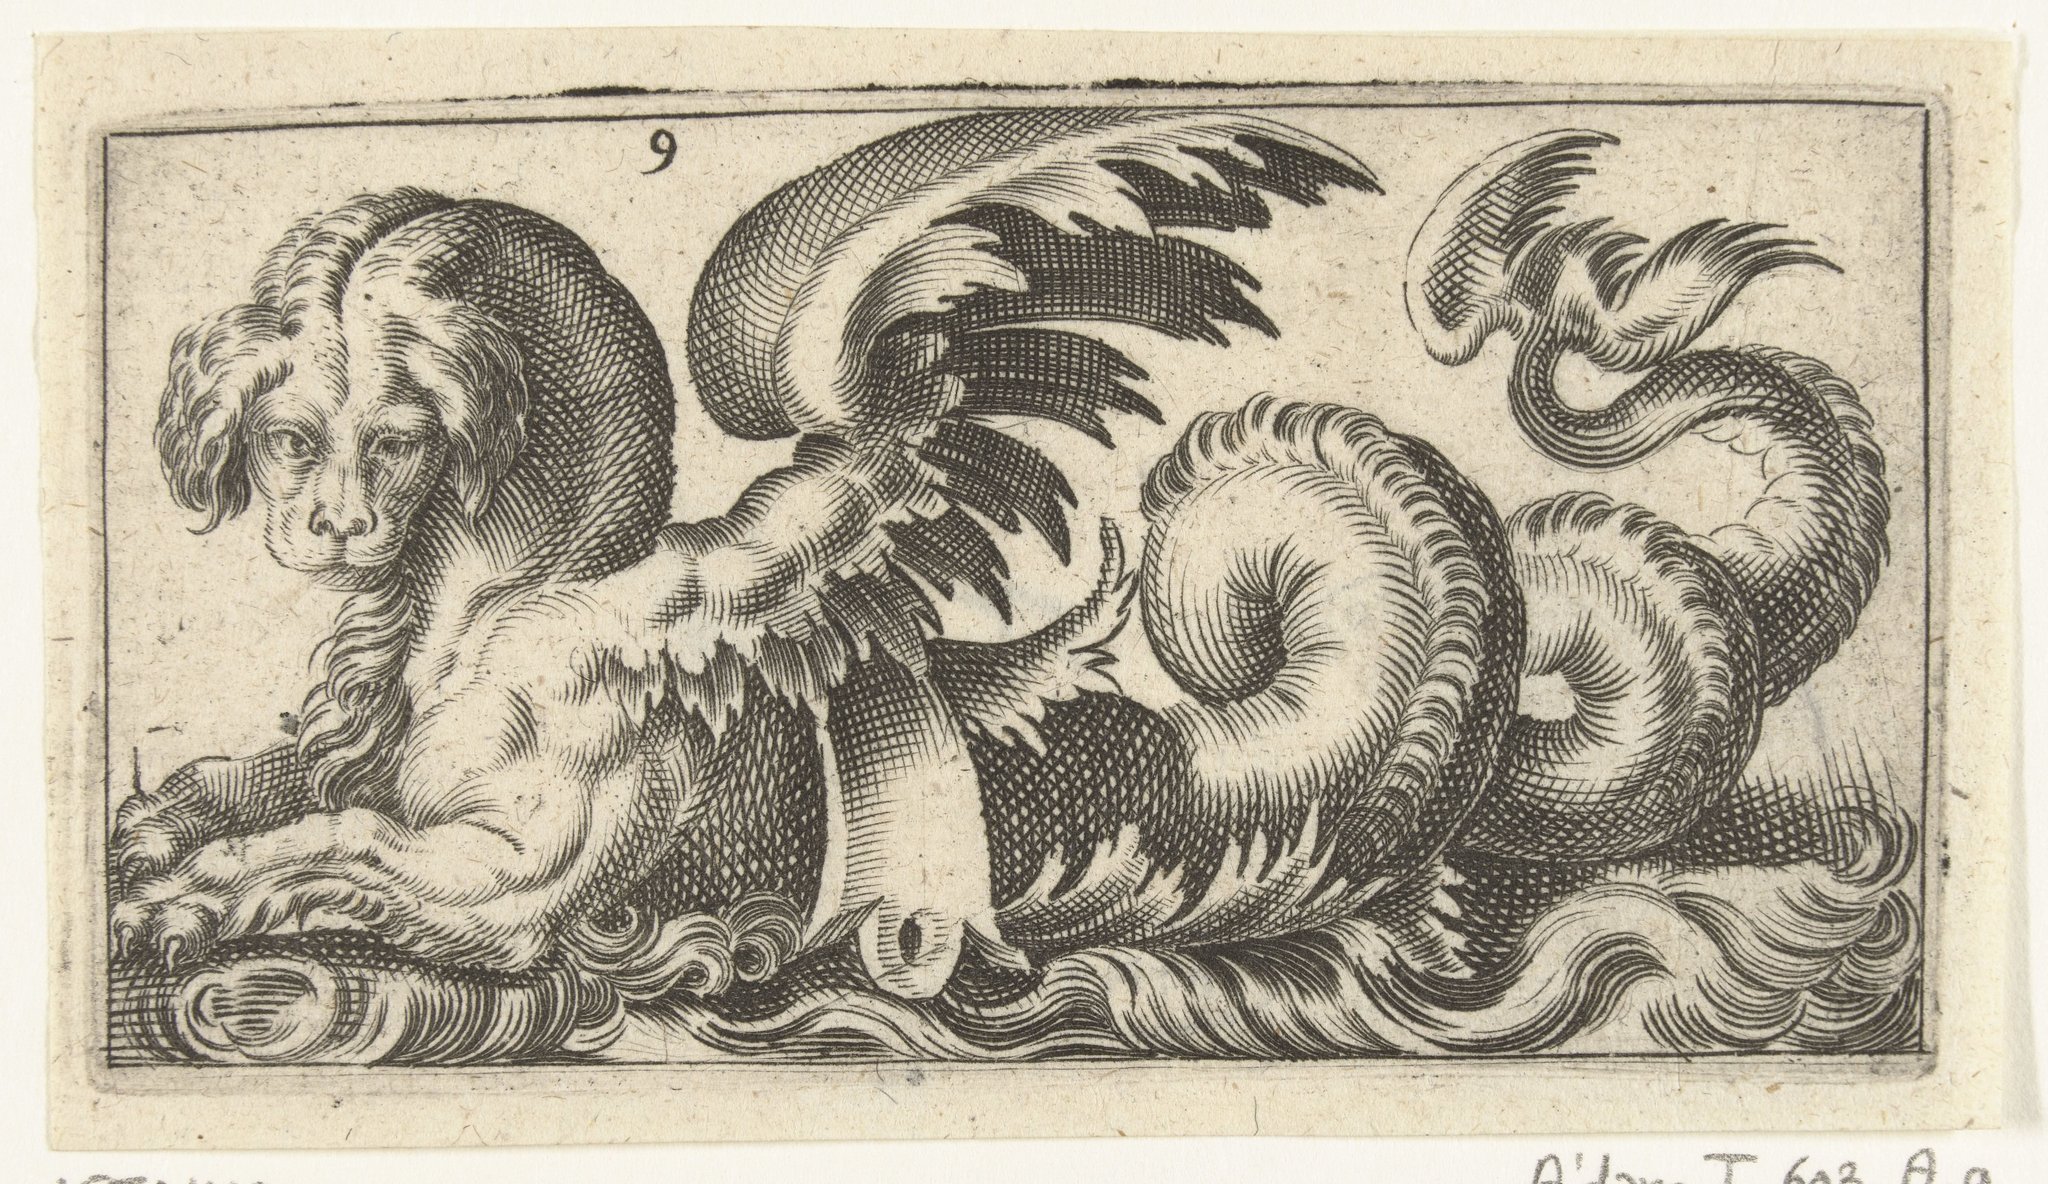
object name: print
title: Gevleugelde zeehond met een soort zadel op zijn rug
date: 1526-1606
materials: paper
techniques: engraving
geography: germany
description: Tegenzijdige kopie naar prent met objectnummer RP-P-1984-443.